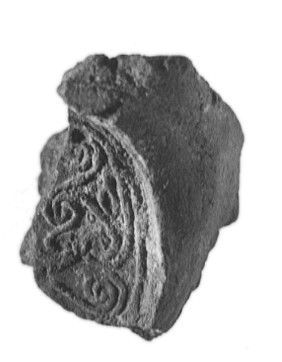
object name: sealing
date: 2030-1640 BCE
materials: clay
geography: egypt